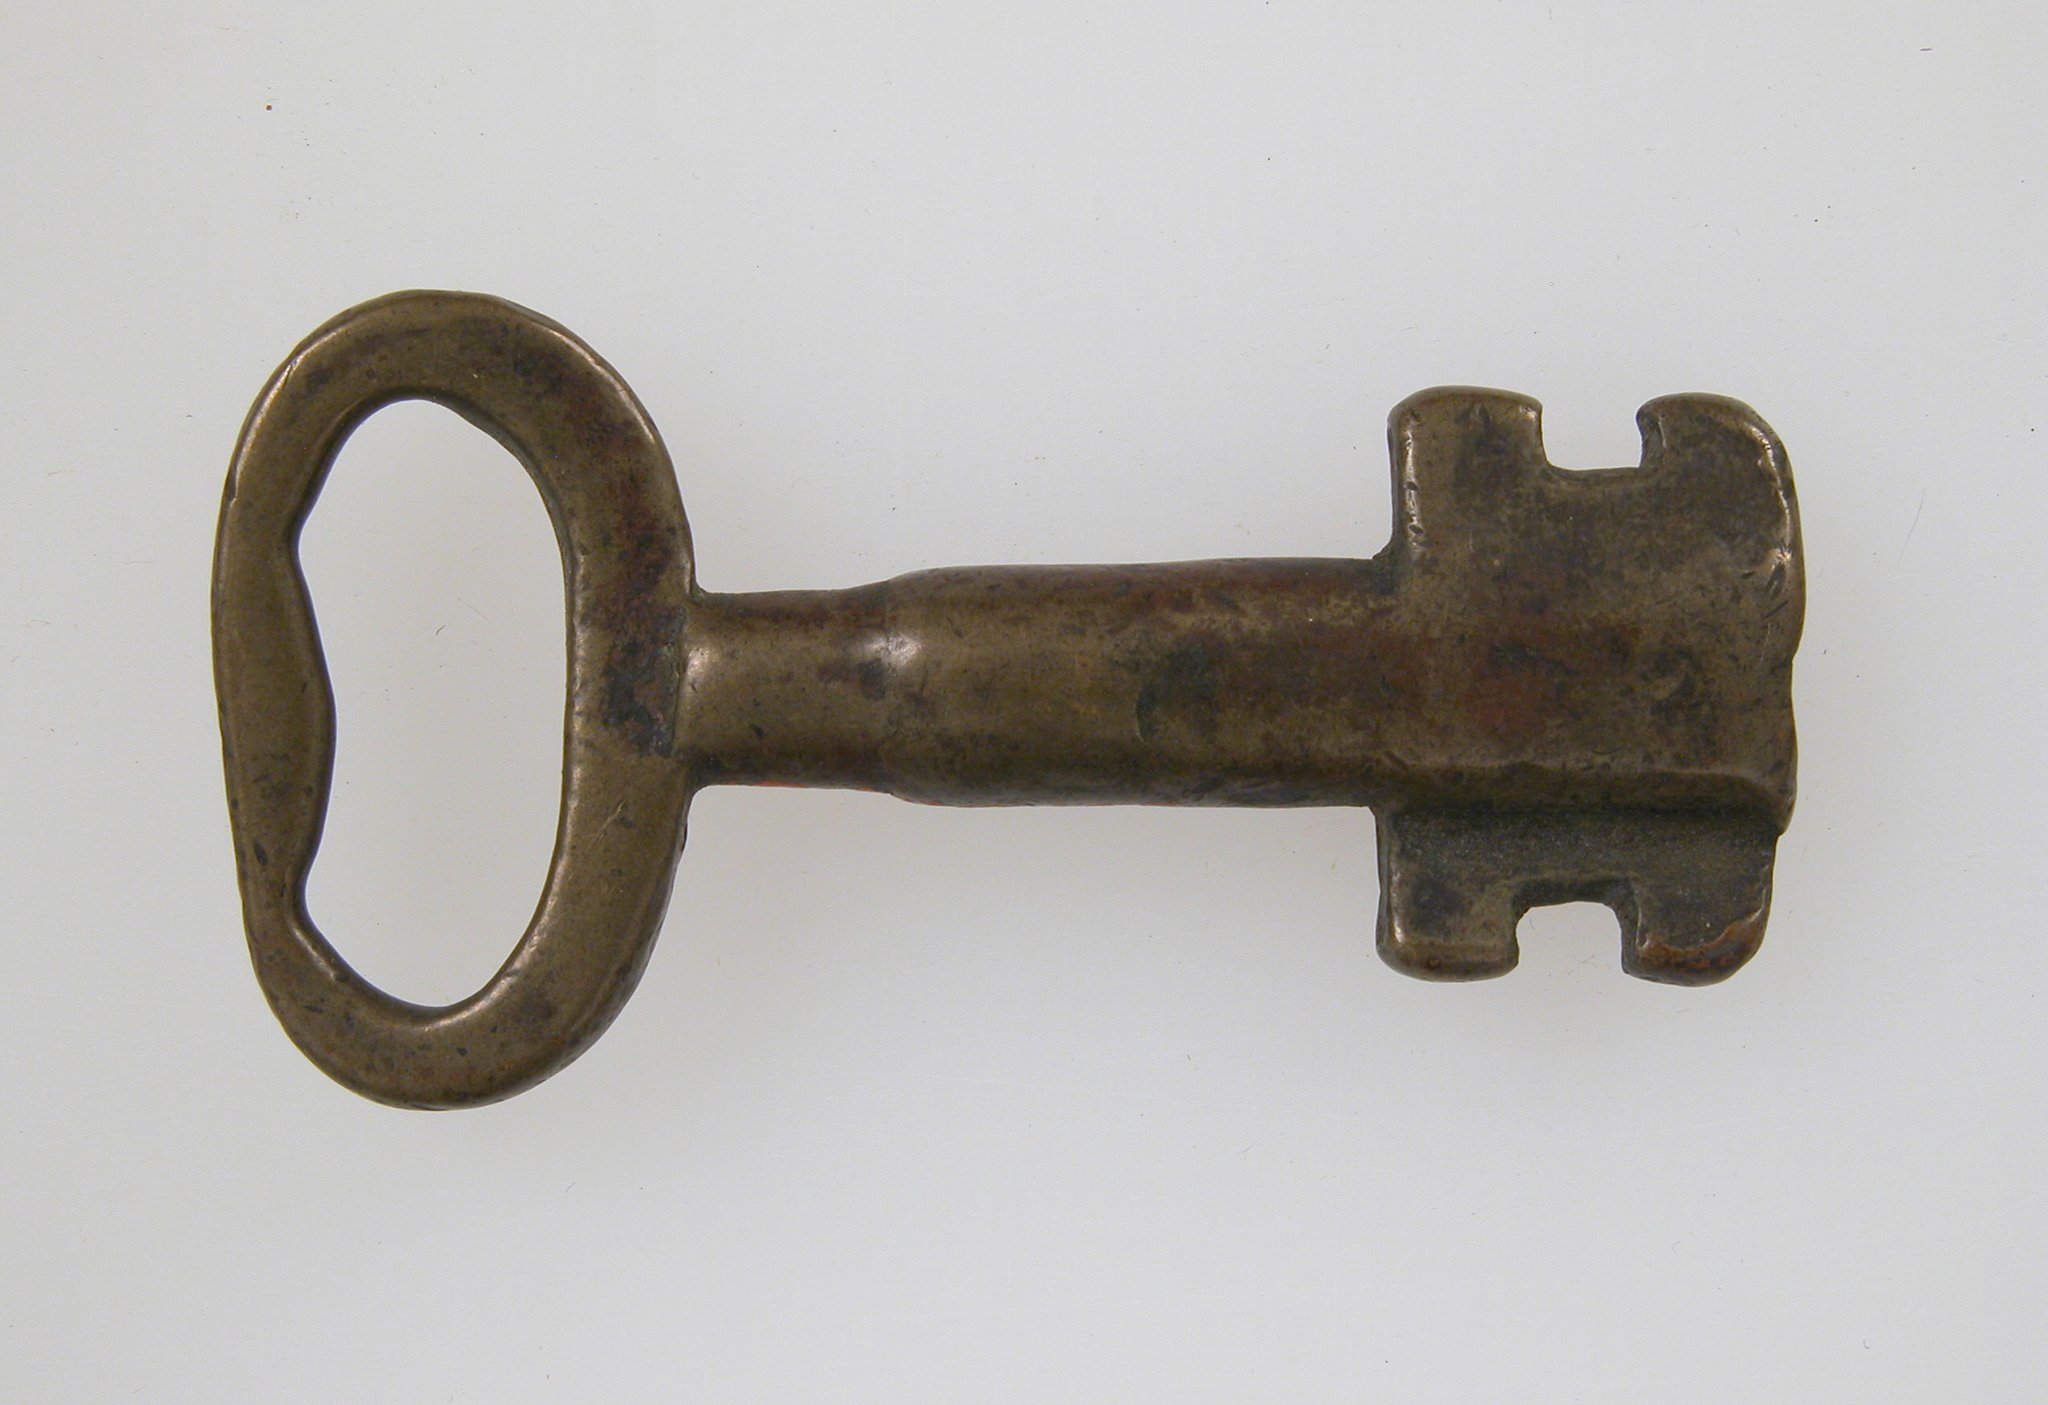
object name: key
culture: german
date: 1301-1400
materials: copper alloy